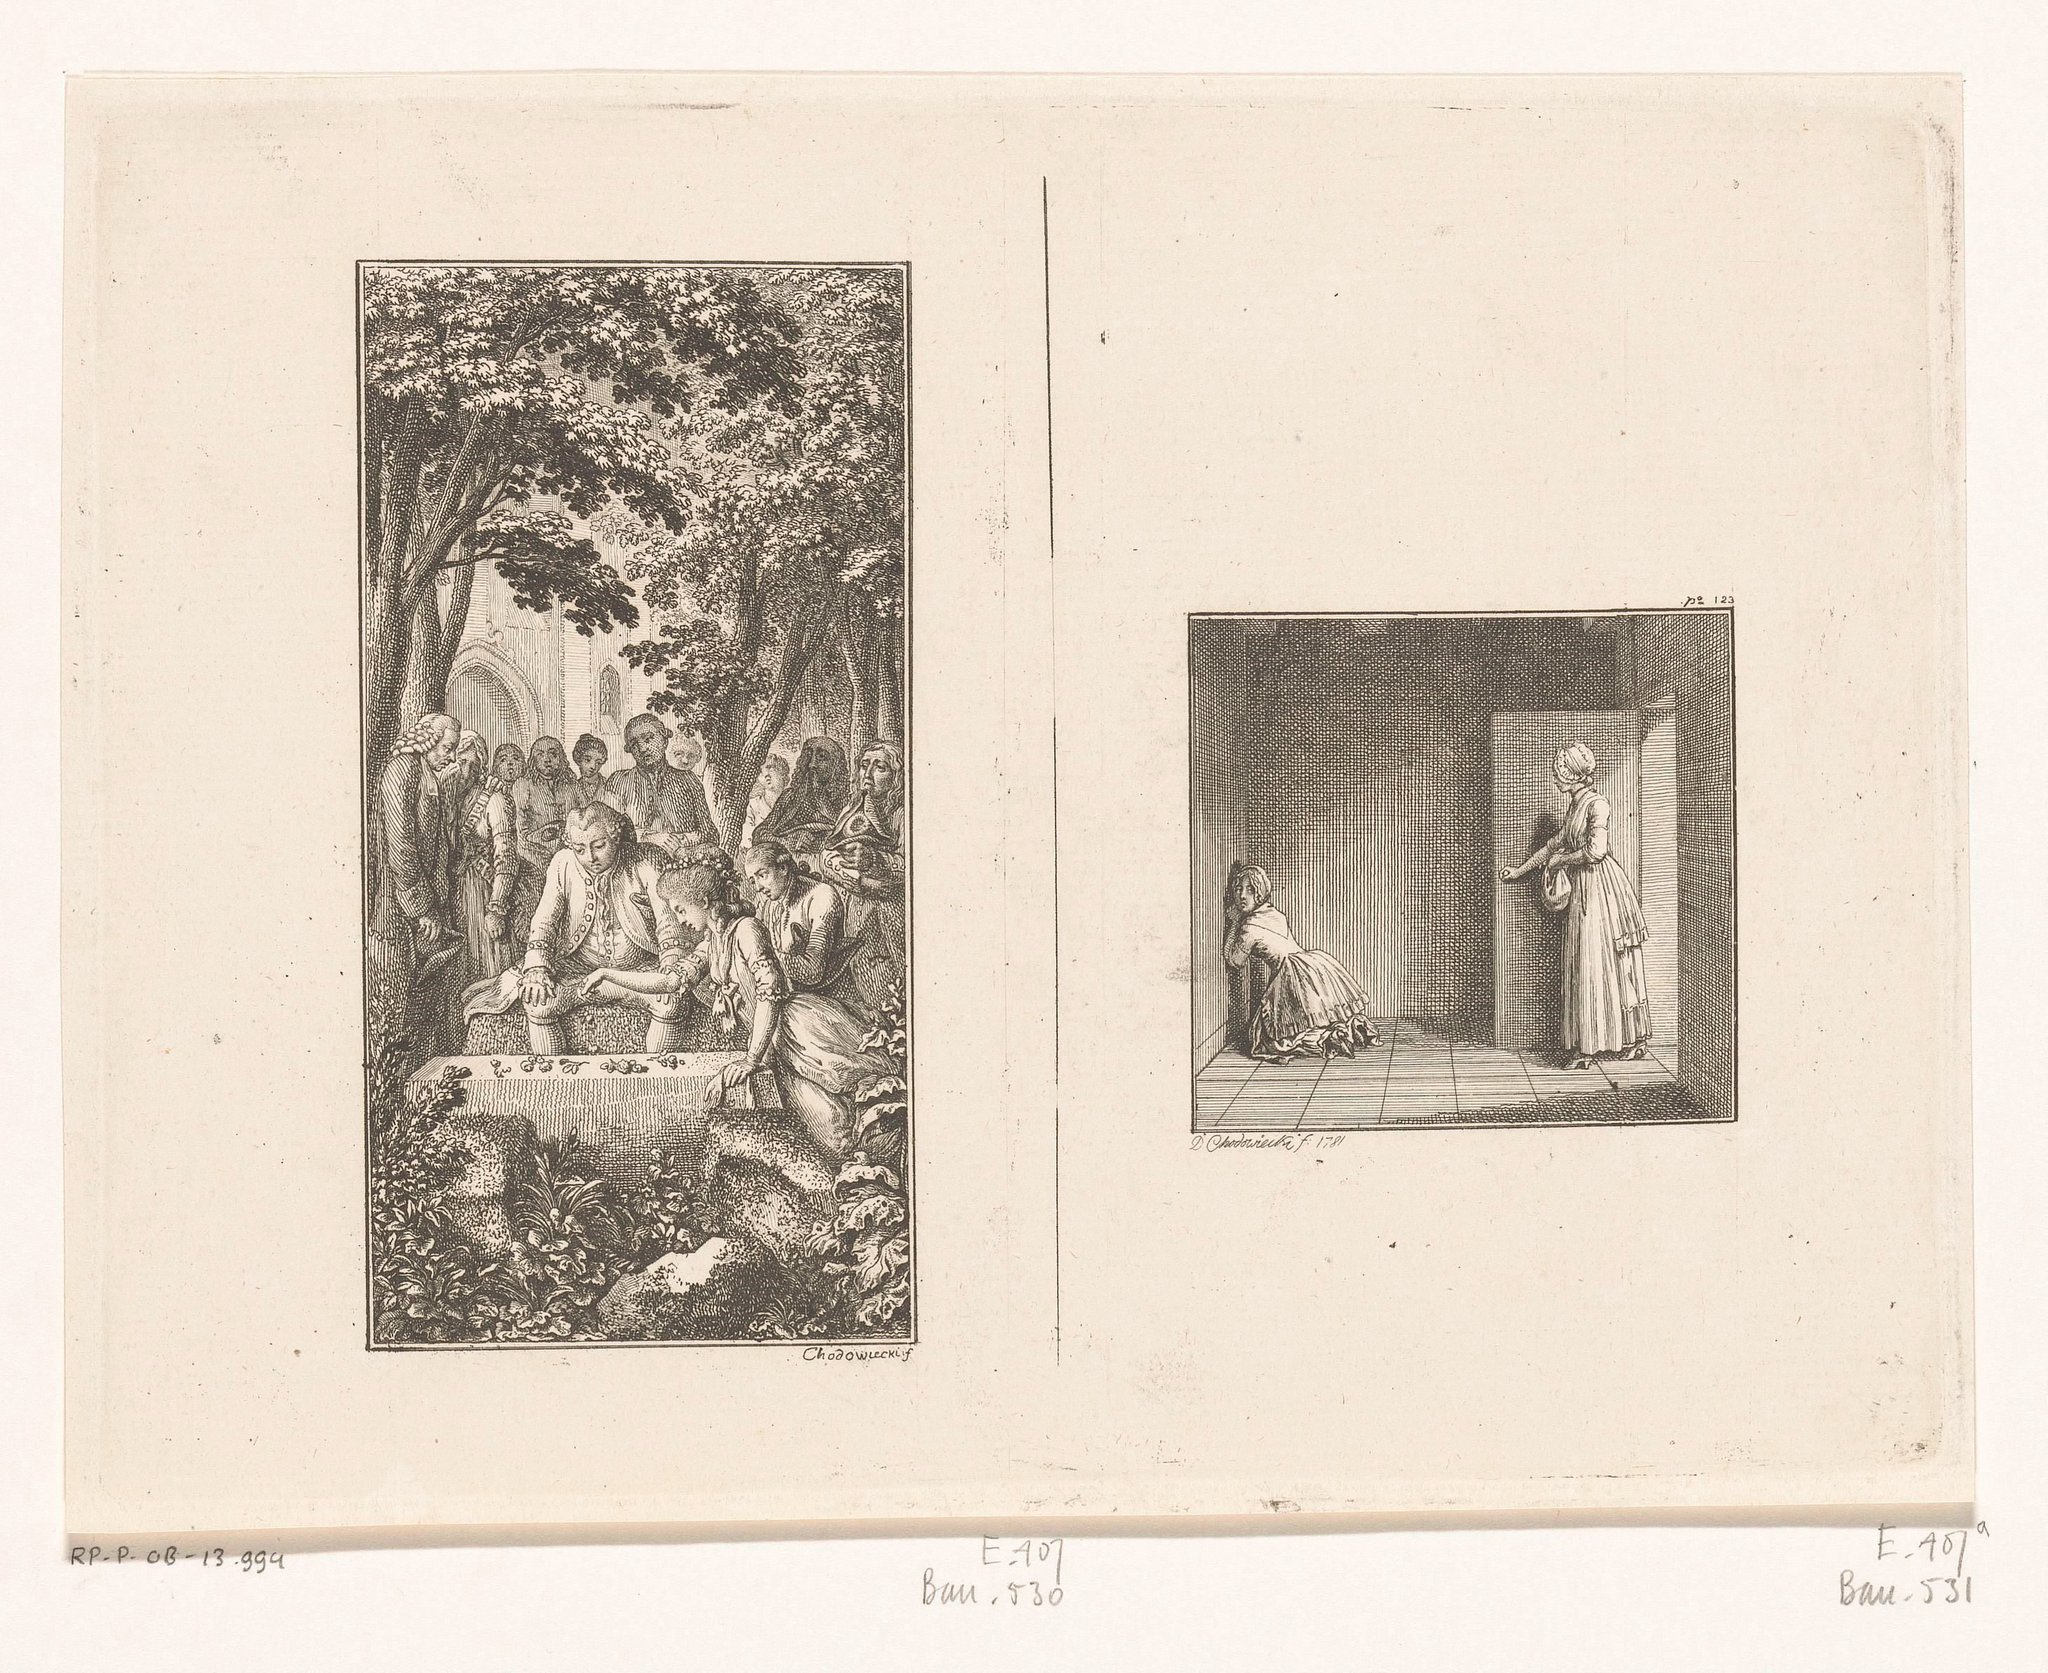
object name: print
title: Gretchen strooit bloemen op het graf van Mine en vrouw uit Koerland in de hoek van een vertrek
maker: daniel nikolaus chodowiecki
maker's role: draughtsman, print maker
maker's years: 1726-1801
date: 1781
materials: paper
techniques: etching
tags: laying flowers or wreath on grave, literature, grave, tomb, kneeling on both knees - aa - female human figure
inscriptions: collector's mark: Lugt 2228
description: Links: Na het huwelijk tussen Gretchen en Nathanael verzamelt het gezelschap zich rond het graf van Mine. Rechts strooit Gretchen bloemen op het graf, naast haar zit Nathanael. Achter Gretchen knielt Alexander. Links staan de predikant en zijn vrouw. Rechts: een vrouw uit Koerland knielt in de hoek van een vertrek. In de deuropening staat een vrouw uit de Heiligen-Geist-Straße die haar eten komt brengen.